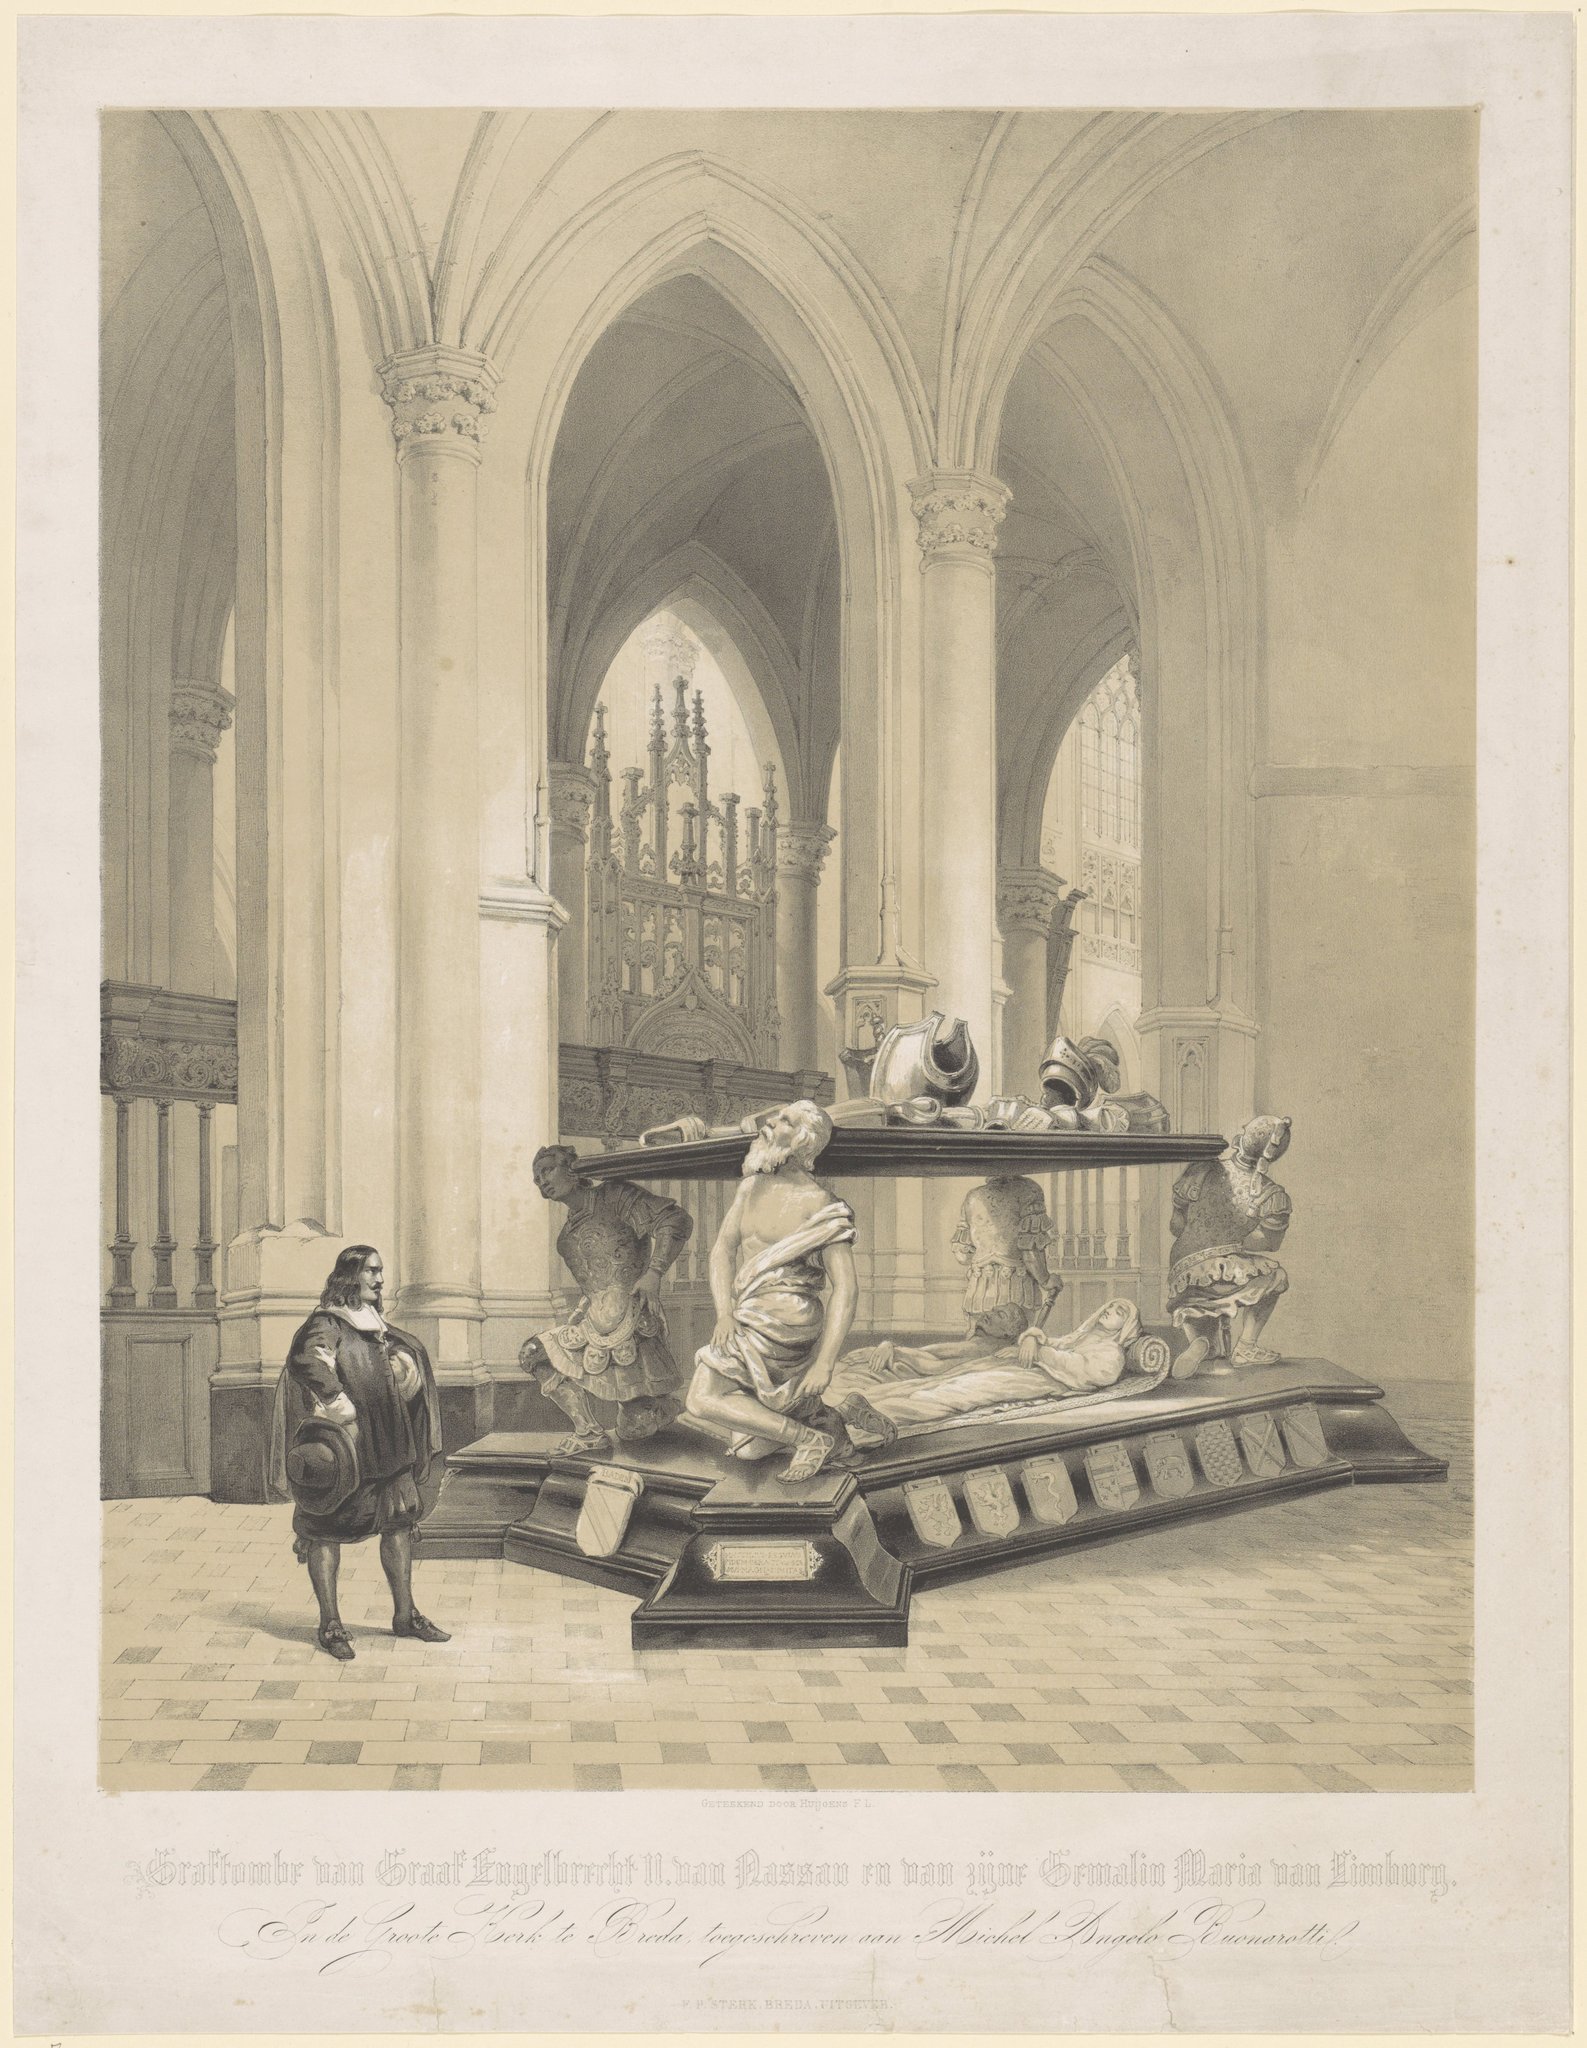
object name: print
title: Grafmonument voor Engelbrecht II, graaf van Nassau-Dillenburg-Breda, 1504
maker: f.p. sterk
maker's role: publisher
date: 1824-1847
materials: paper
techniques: lithograph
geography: breda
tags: brussels, interior of church, grave-building, monumental tomb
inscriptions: collector's mark: Lugt 963, collector's mark: Lugt 2166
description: Grafmonument voor Engelbrecht II in de Prinsenkapel van de Onze-Lieve-Vrouwekerk te Breda, overleden op 31 mei 1504. Links staat een figuur. In de ondermarge een regel Nederlandse tekst. Losse verklarende tekst in boekdruk.